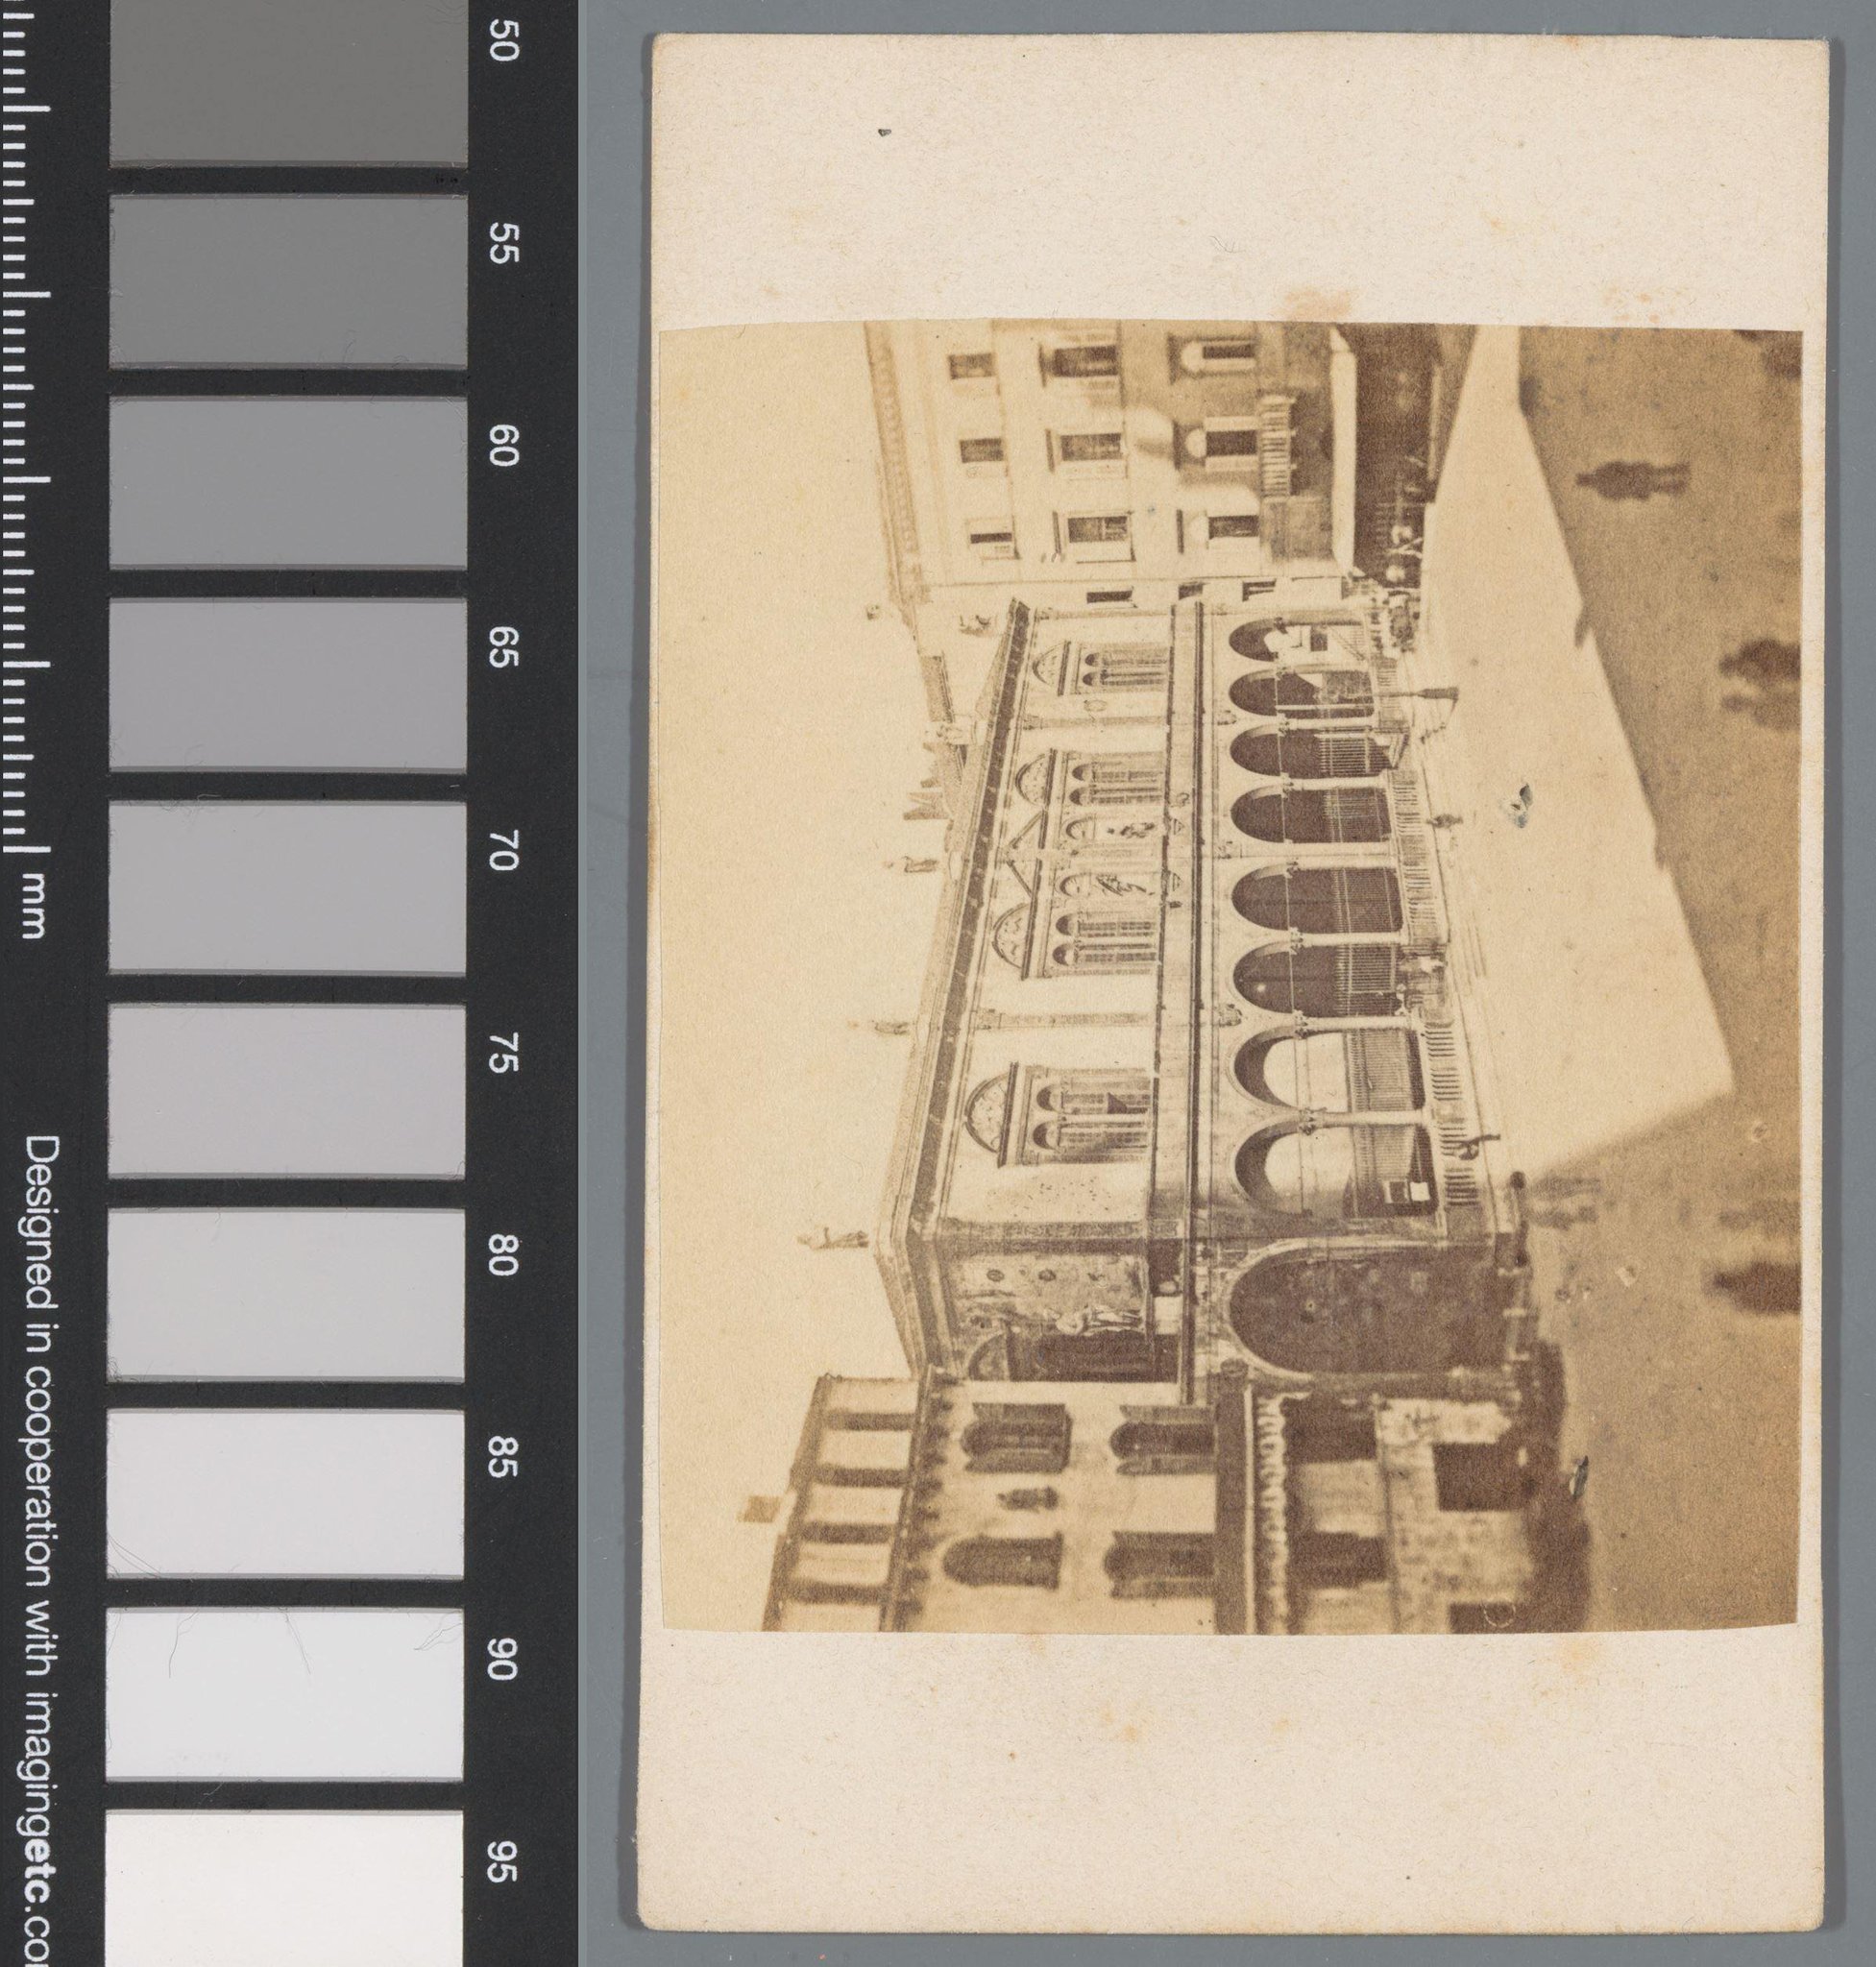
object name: photograph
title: Loggia del Consiglio aan het Piazza dei Signori, Verona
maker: Anonymous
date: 1855-1885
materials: cardboard, paper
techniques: albumen print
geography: verona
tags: square, place, circus, etc., loggia, verandah, porch